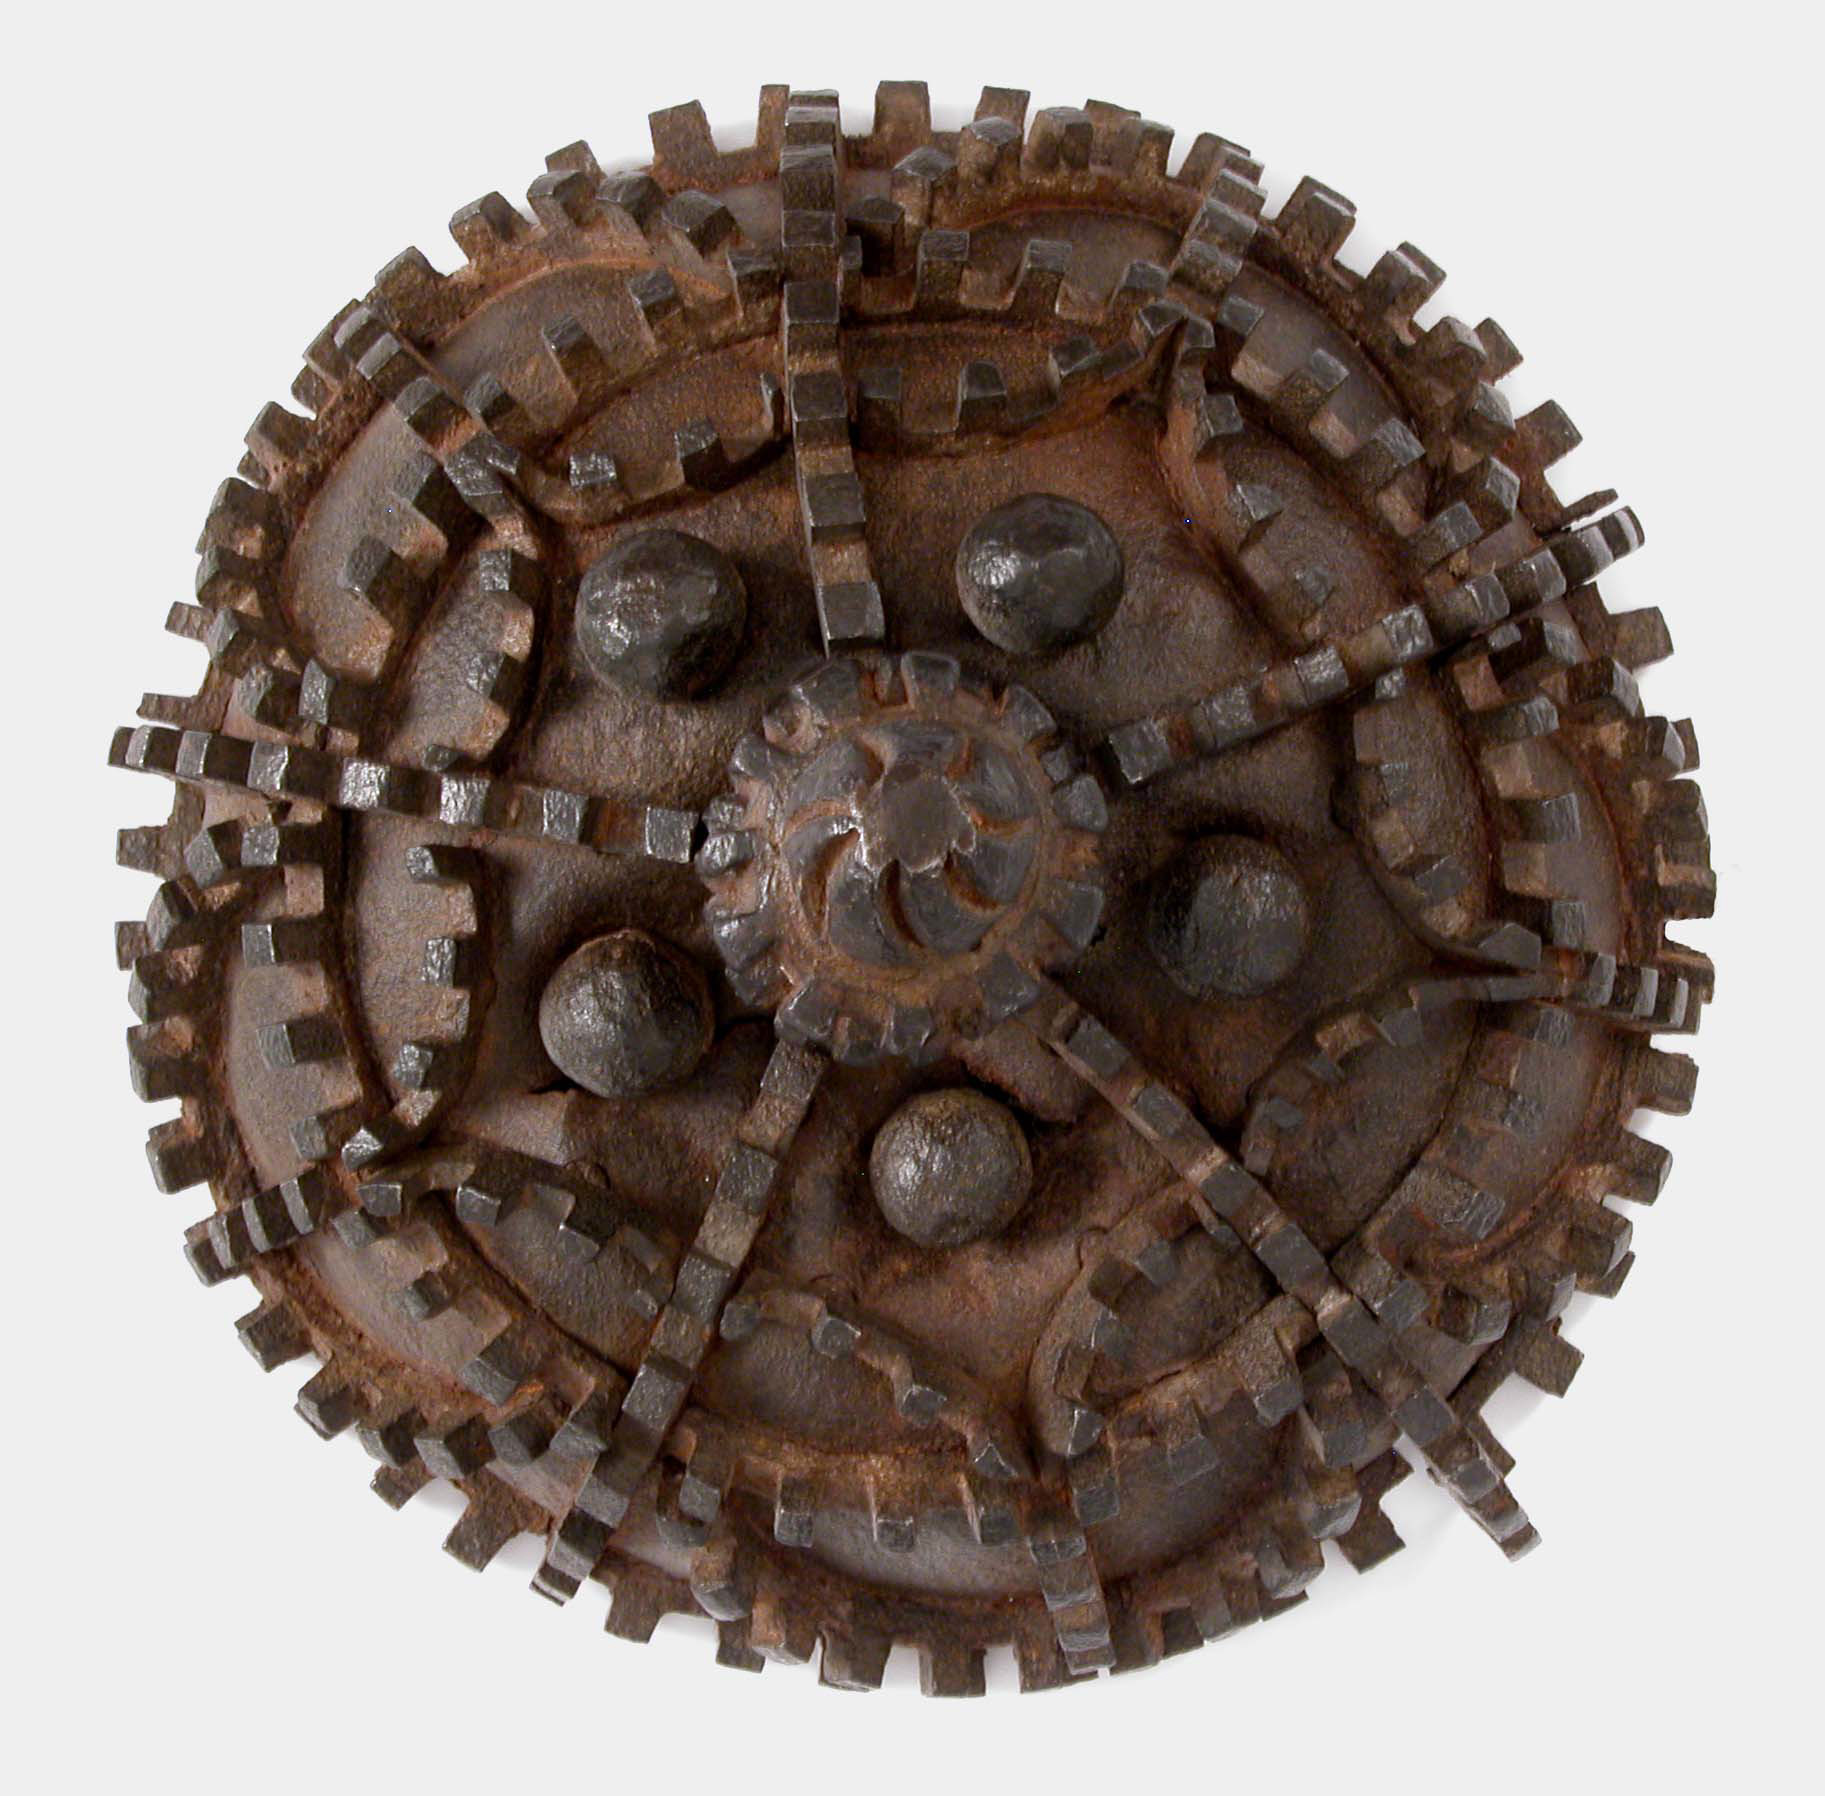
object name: door bos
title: Door Boss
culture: european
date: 1401-1600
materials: iron